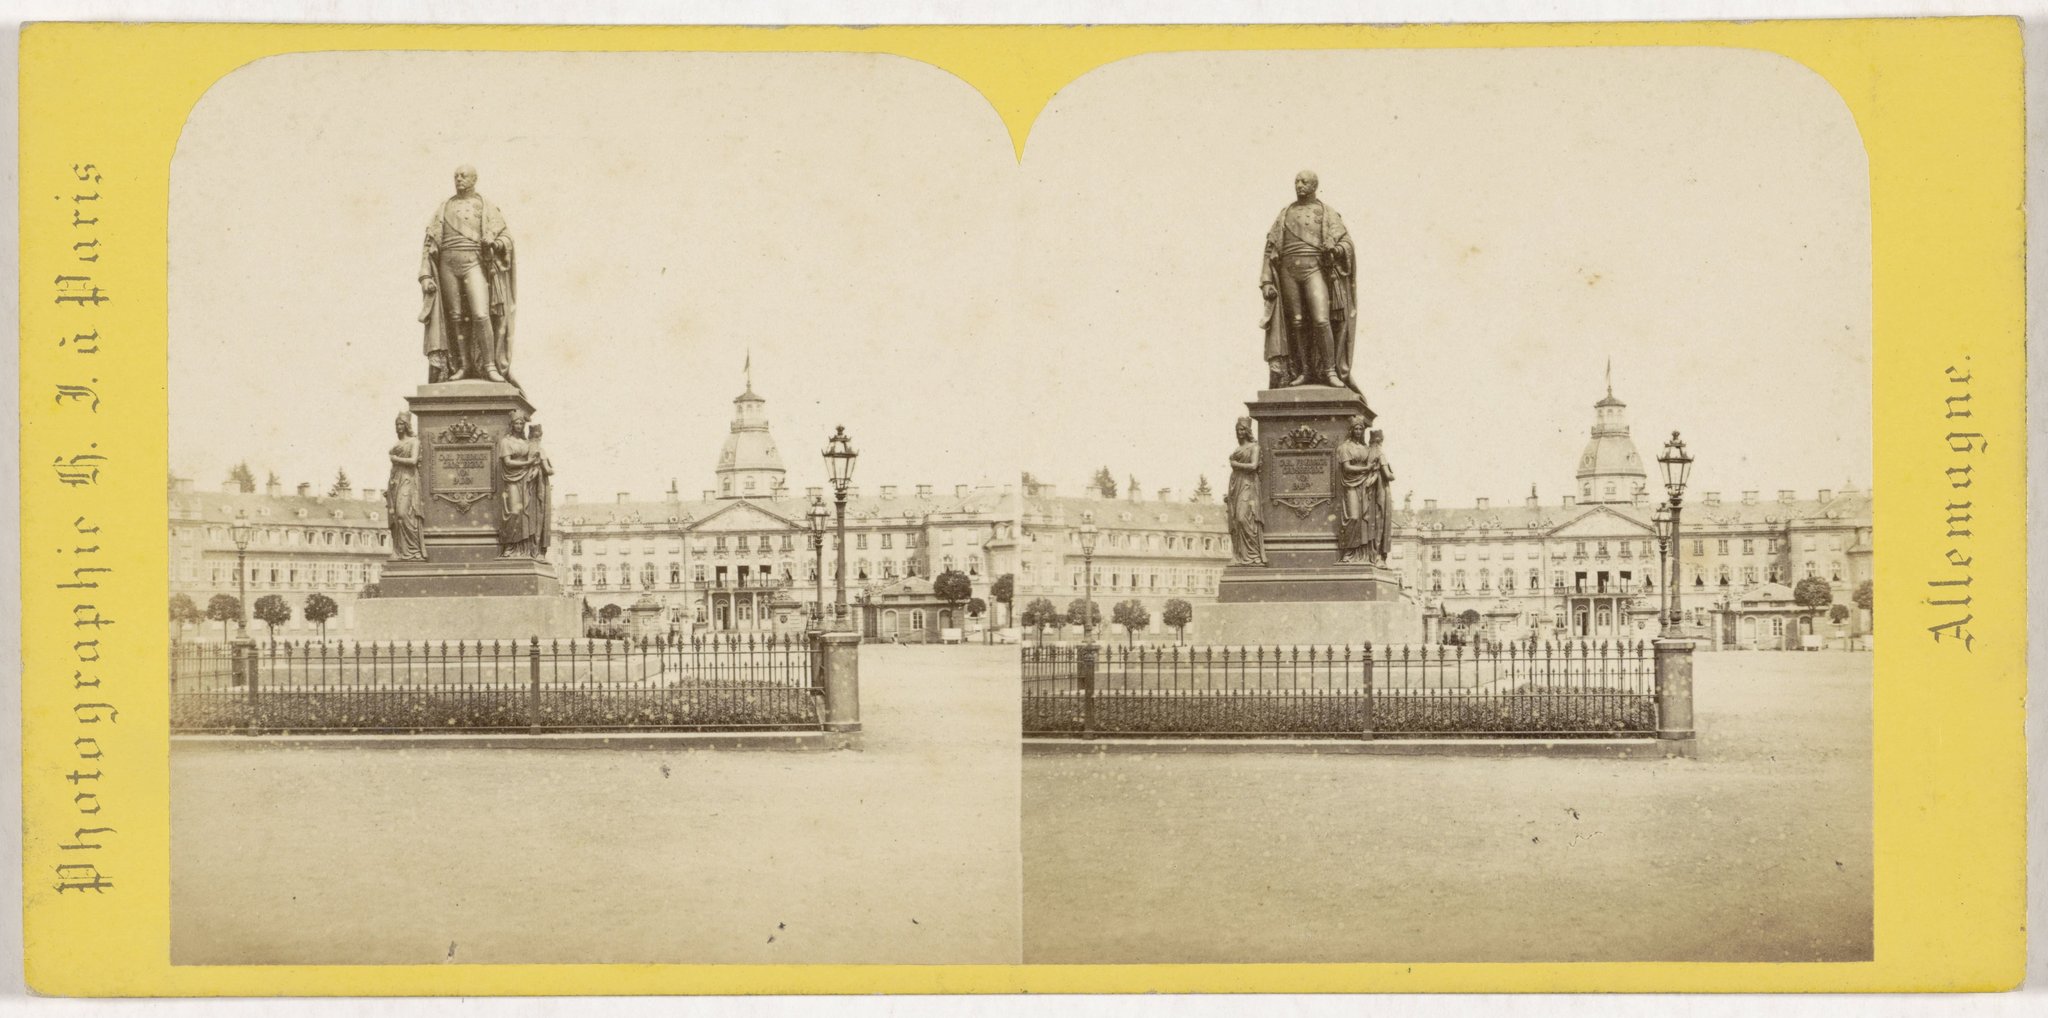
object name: stereograph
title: Allemagne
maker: hippolyte jouvin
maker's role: fotograaf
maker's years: 1825-1889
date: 1860-1865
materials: cardboard, paper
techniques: albumen print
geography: baden-baden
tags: square, place, circus, etc., monument, statue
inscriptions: number: ‘N. 337’